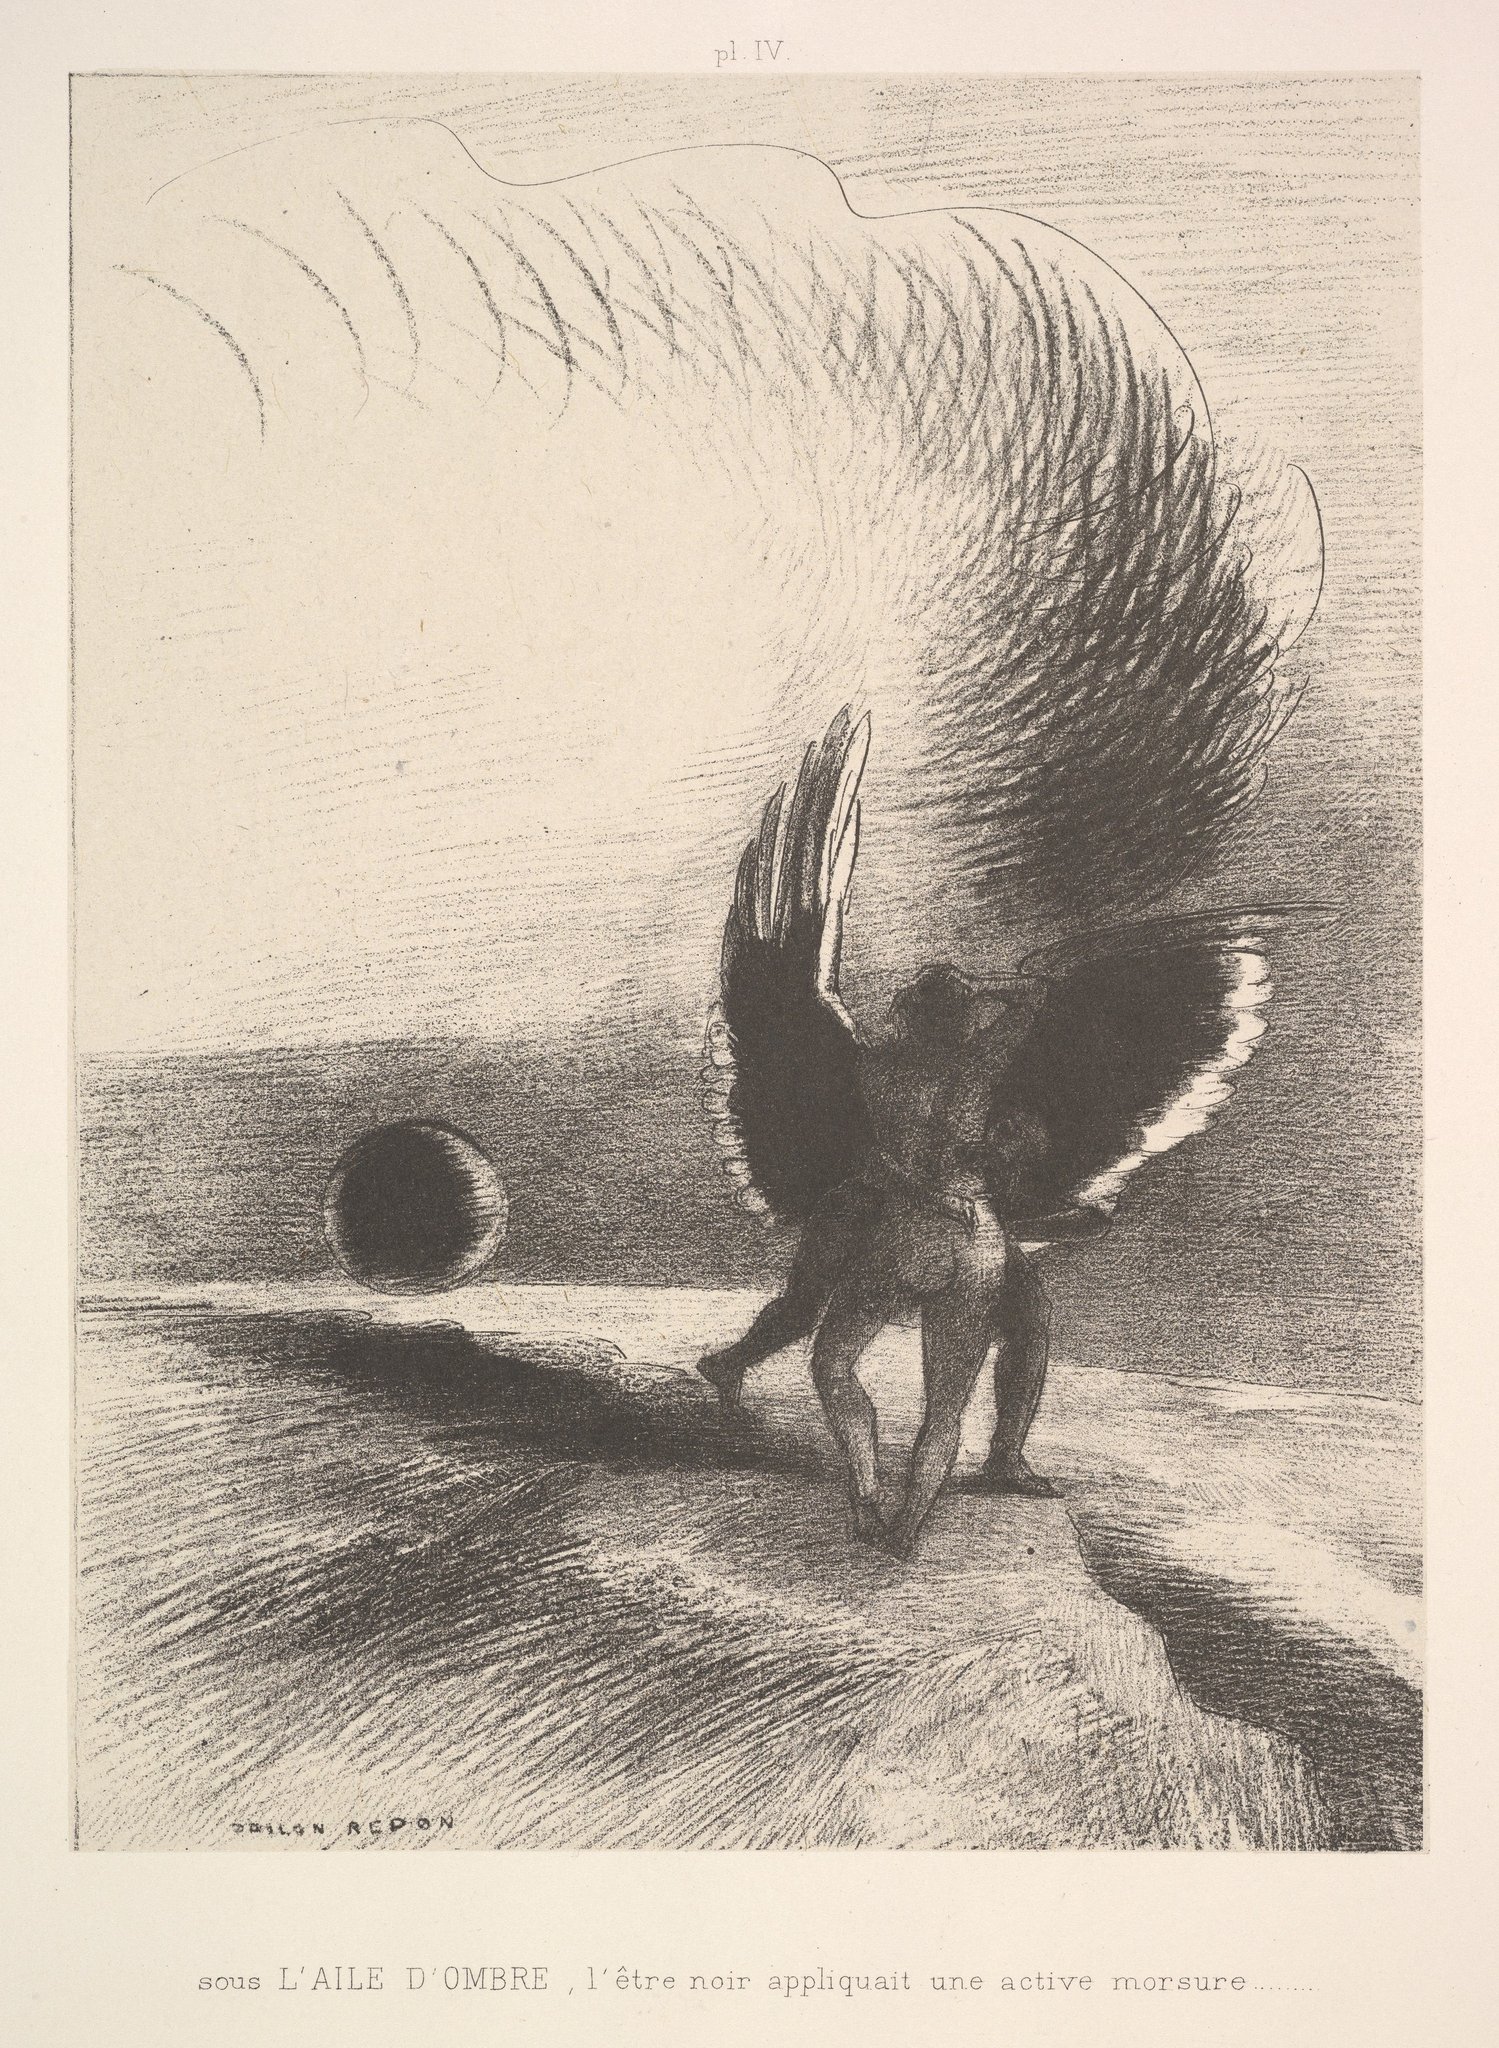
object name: print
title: In the shadow of the wing, the black creature bit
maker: odilon redon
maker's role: artist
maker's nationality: french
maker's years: 1840-1916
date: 1891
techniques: lithograph